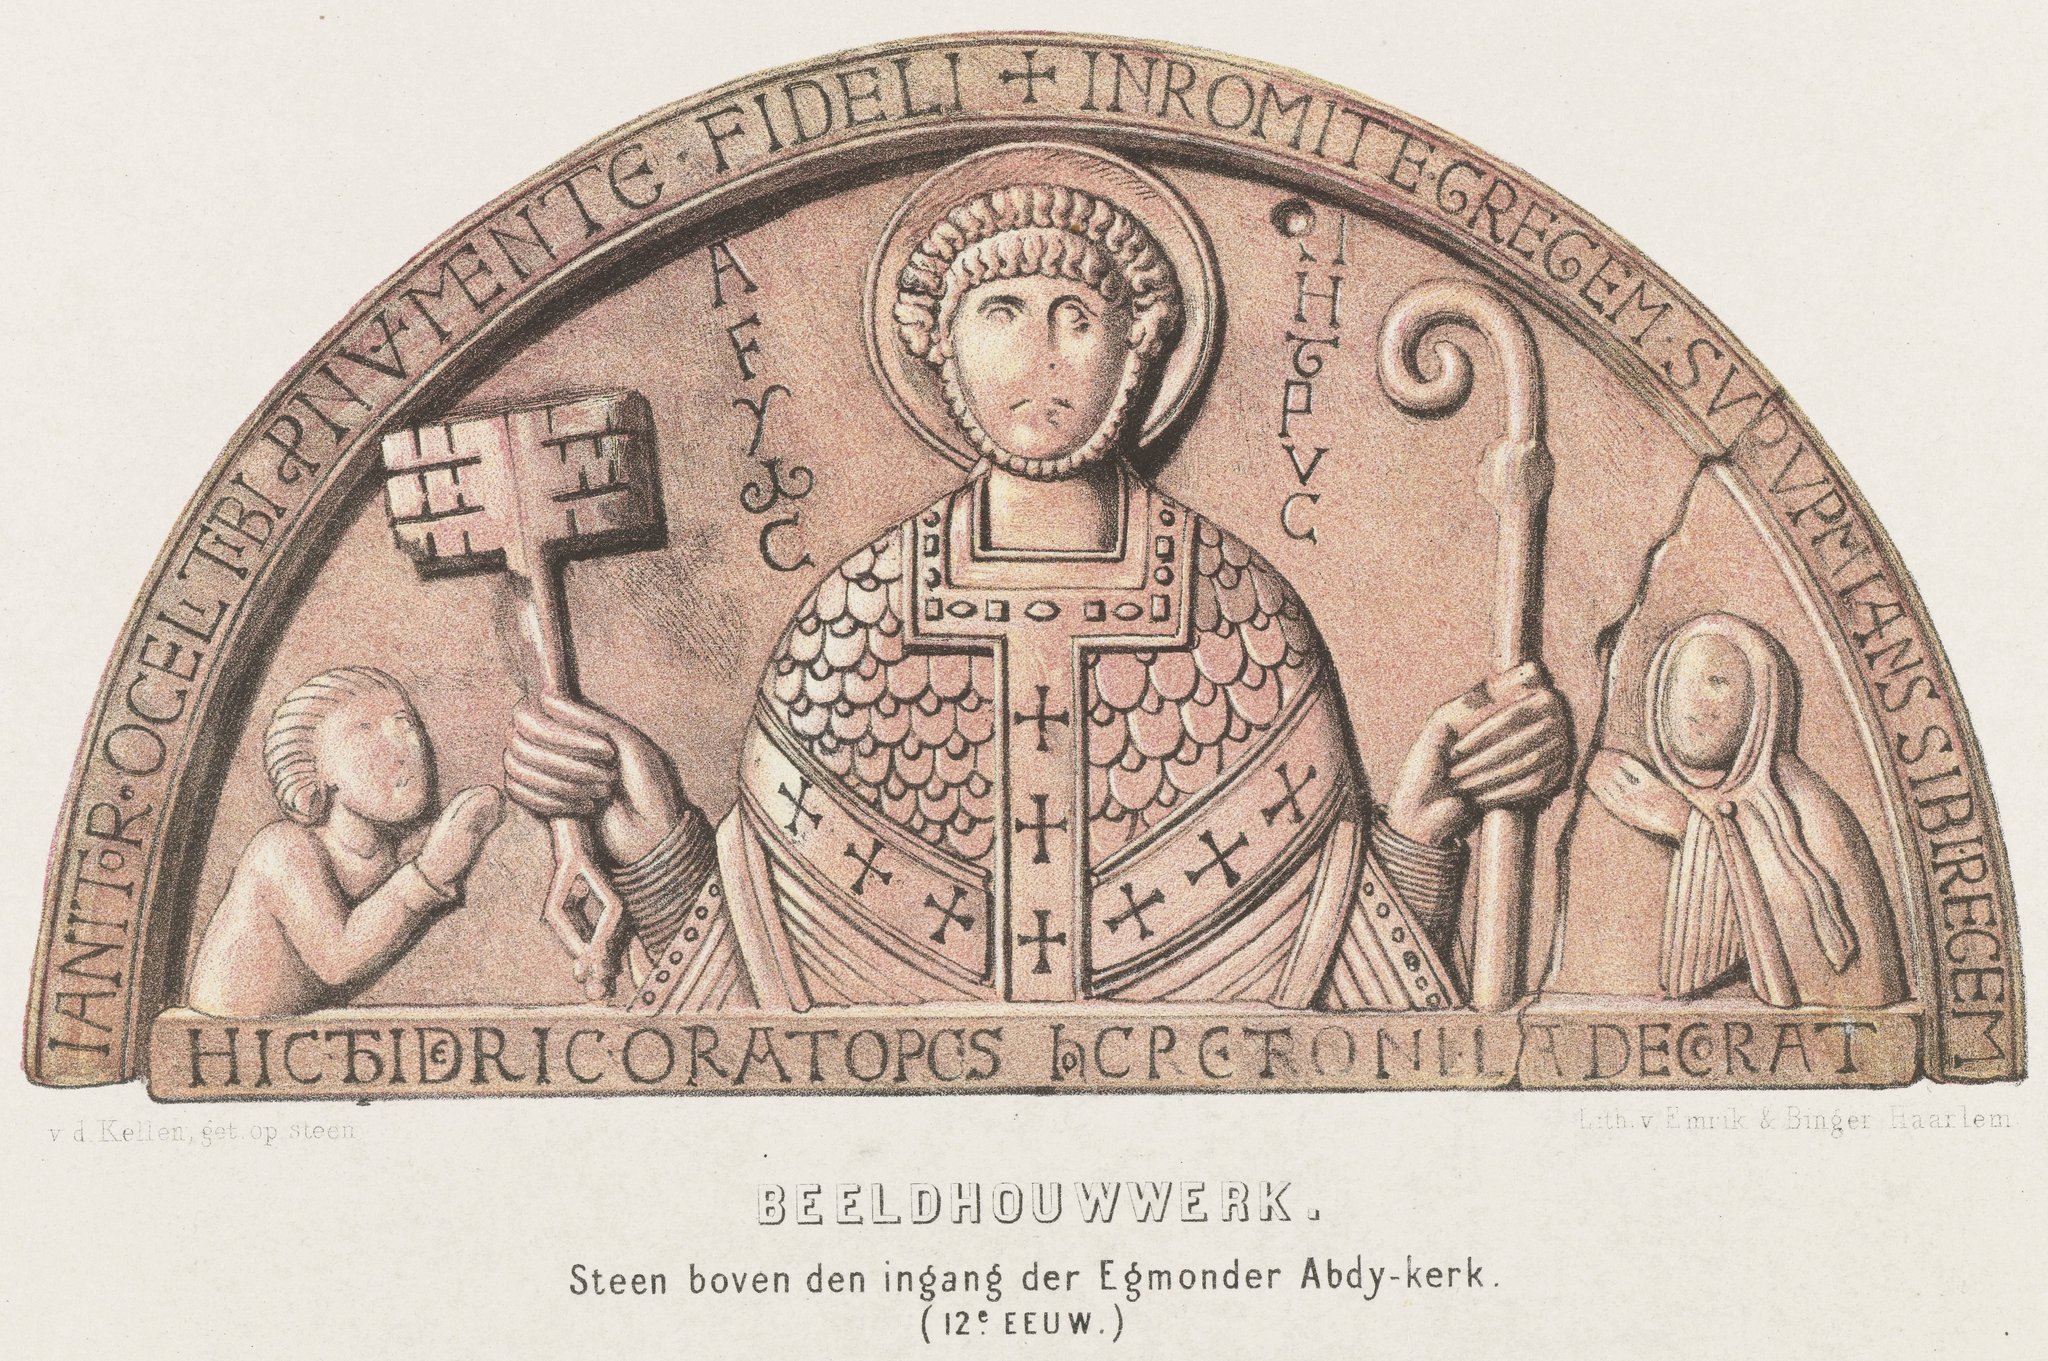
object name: historical object representation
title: Timpaan van Egmond: boogtrommel met Petrus, graaf Dirk VI van Holland en zijn moeder gravin Petronella, ca. 1120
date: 1857-1864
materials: paper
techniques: lithograph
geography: haarlem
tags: piece of sculpture, reproduction of a piece of sculpture, art (+ relief ~ sculpture)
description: Timpaan van de abdij van Egmond: boogtrommel met Petrus, graaf Dirk VI van Holland en zijn moeder gravin Petronella. Het geheel omringd met Latijnse inscripties. De steen is afkomstig uit de voormalige Benedictijner Abdij van St. Petrus en St. Adelbert te Egmond-Binnen. Muller plaatst de voorstellingen van deze steen in het jaar 1009, in werkelijkheid is de steen vervaardigd ca. 1120.